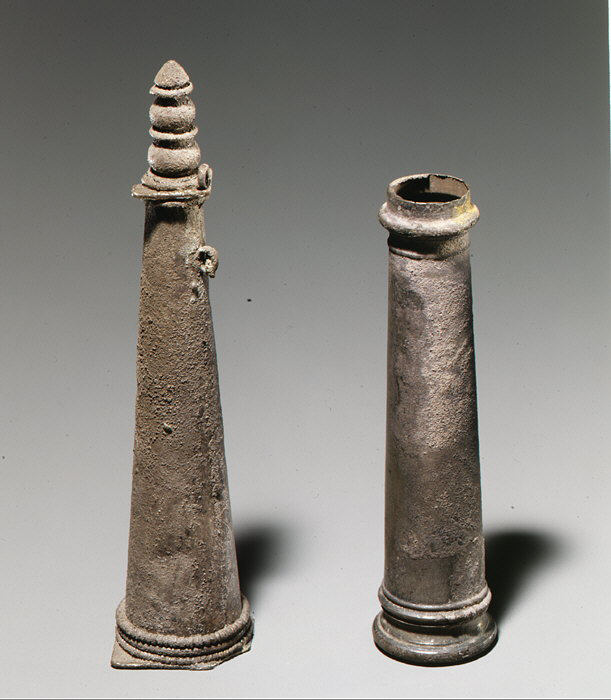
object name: cosmetic vessel with lid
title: Silver cosmetic vessel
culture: east greek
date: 600-501 BCE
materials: silver